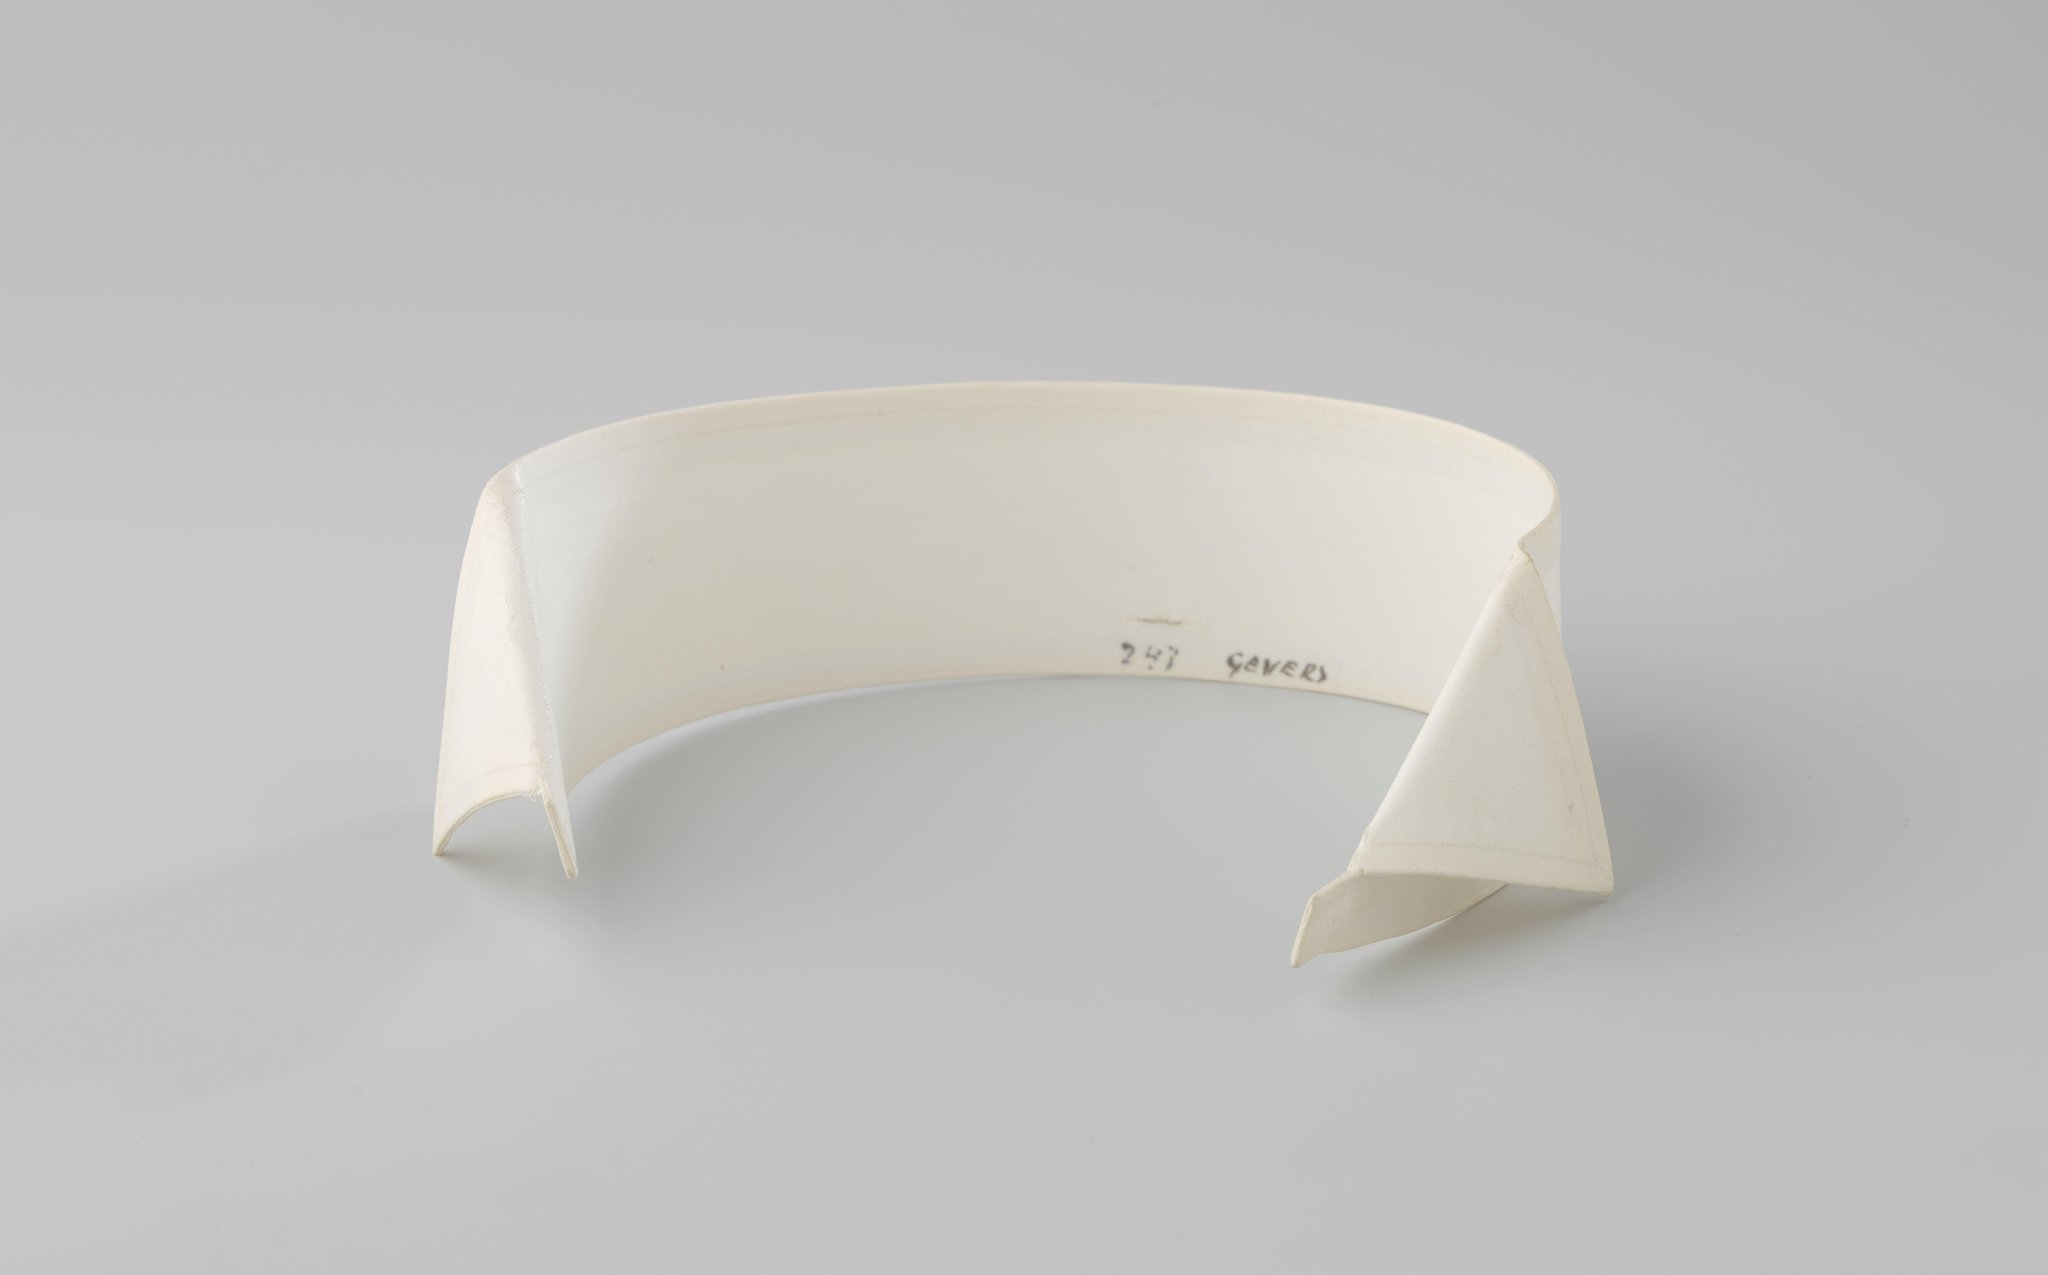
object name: collar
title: Vadermoordenaar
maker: Anonymous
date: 1850-1920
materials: textile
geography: netherlands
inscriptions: inscription: ‘247 GEVERS’